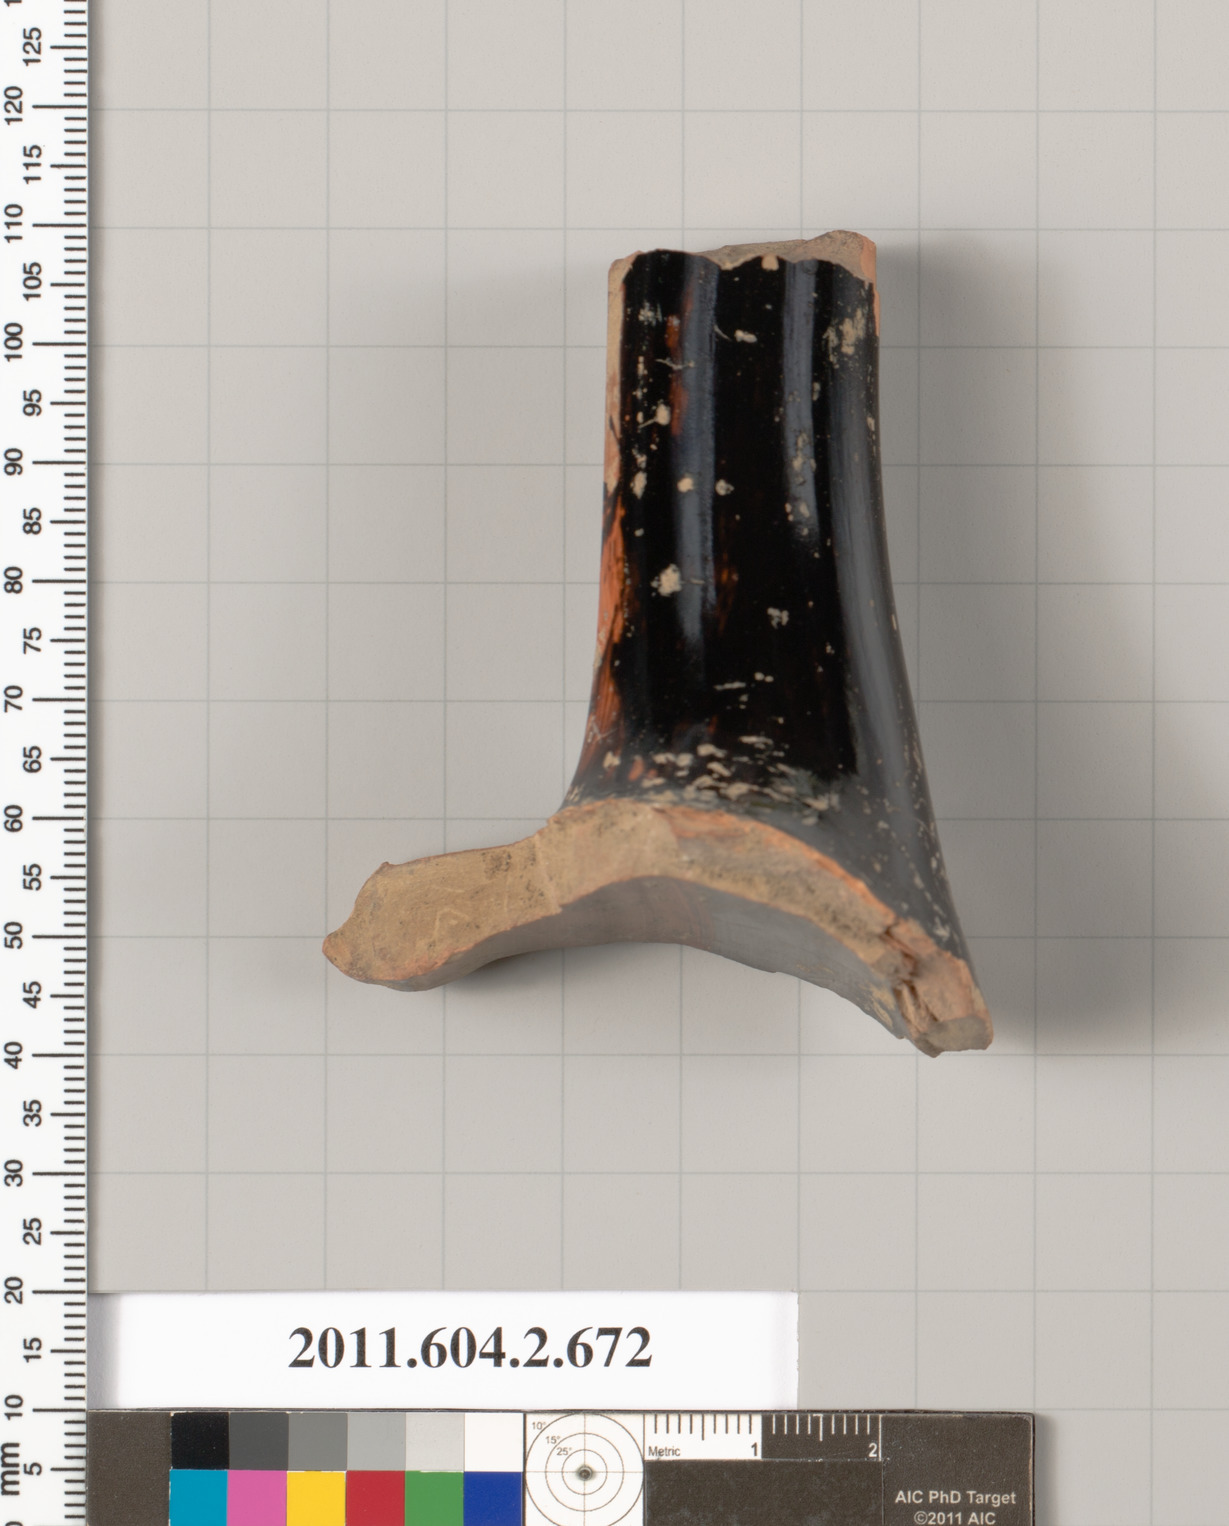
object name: column krater fragment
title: Terracotta fragment of a column-krater (bowl for mixing wine and water)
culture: greek, attic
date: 475-451 BCE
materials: terracotta